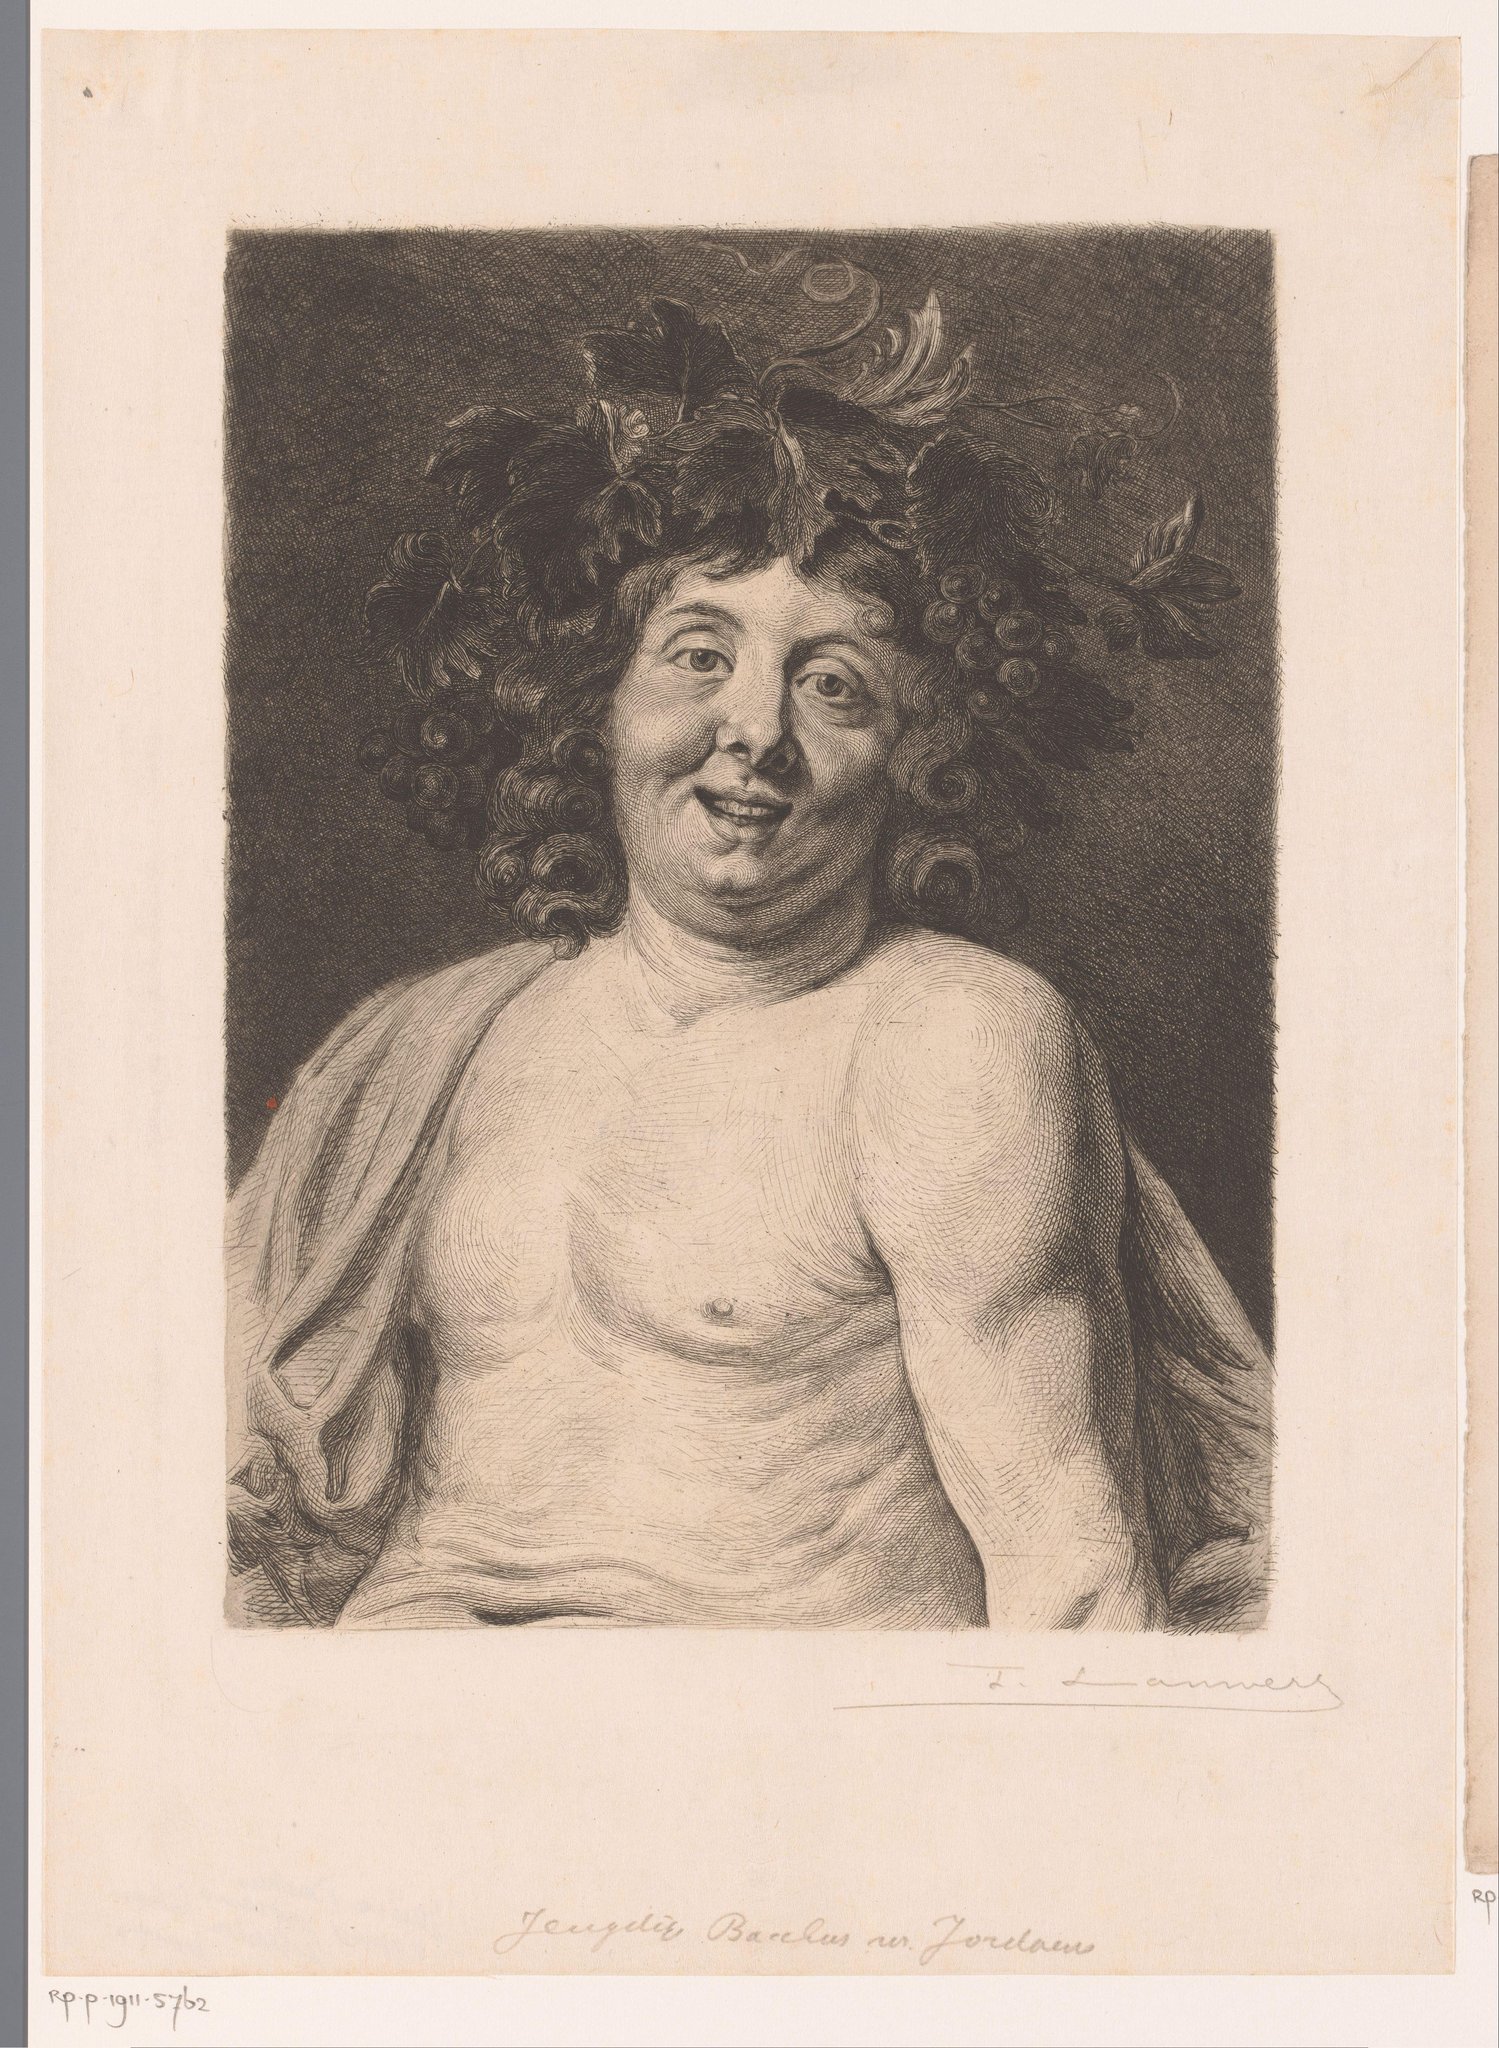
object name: print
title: Kop van de jonge Bacchus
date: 1864-1911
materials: paper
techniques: etching, intaglio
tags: (story of) bacchus (dionysus), liber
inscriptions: collector's mark: Lugt 2228, workshop stamp: ‘Antwerpsche Etsers 1880’